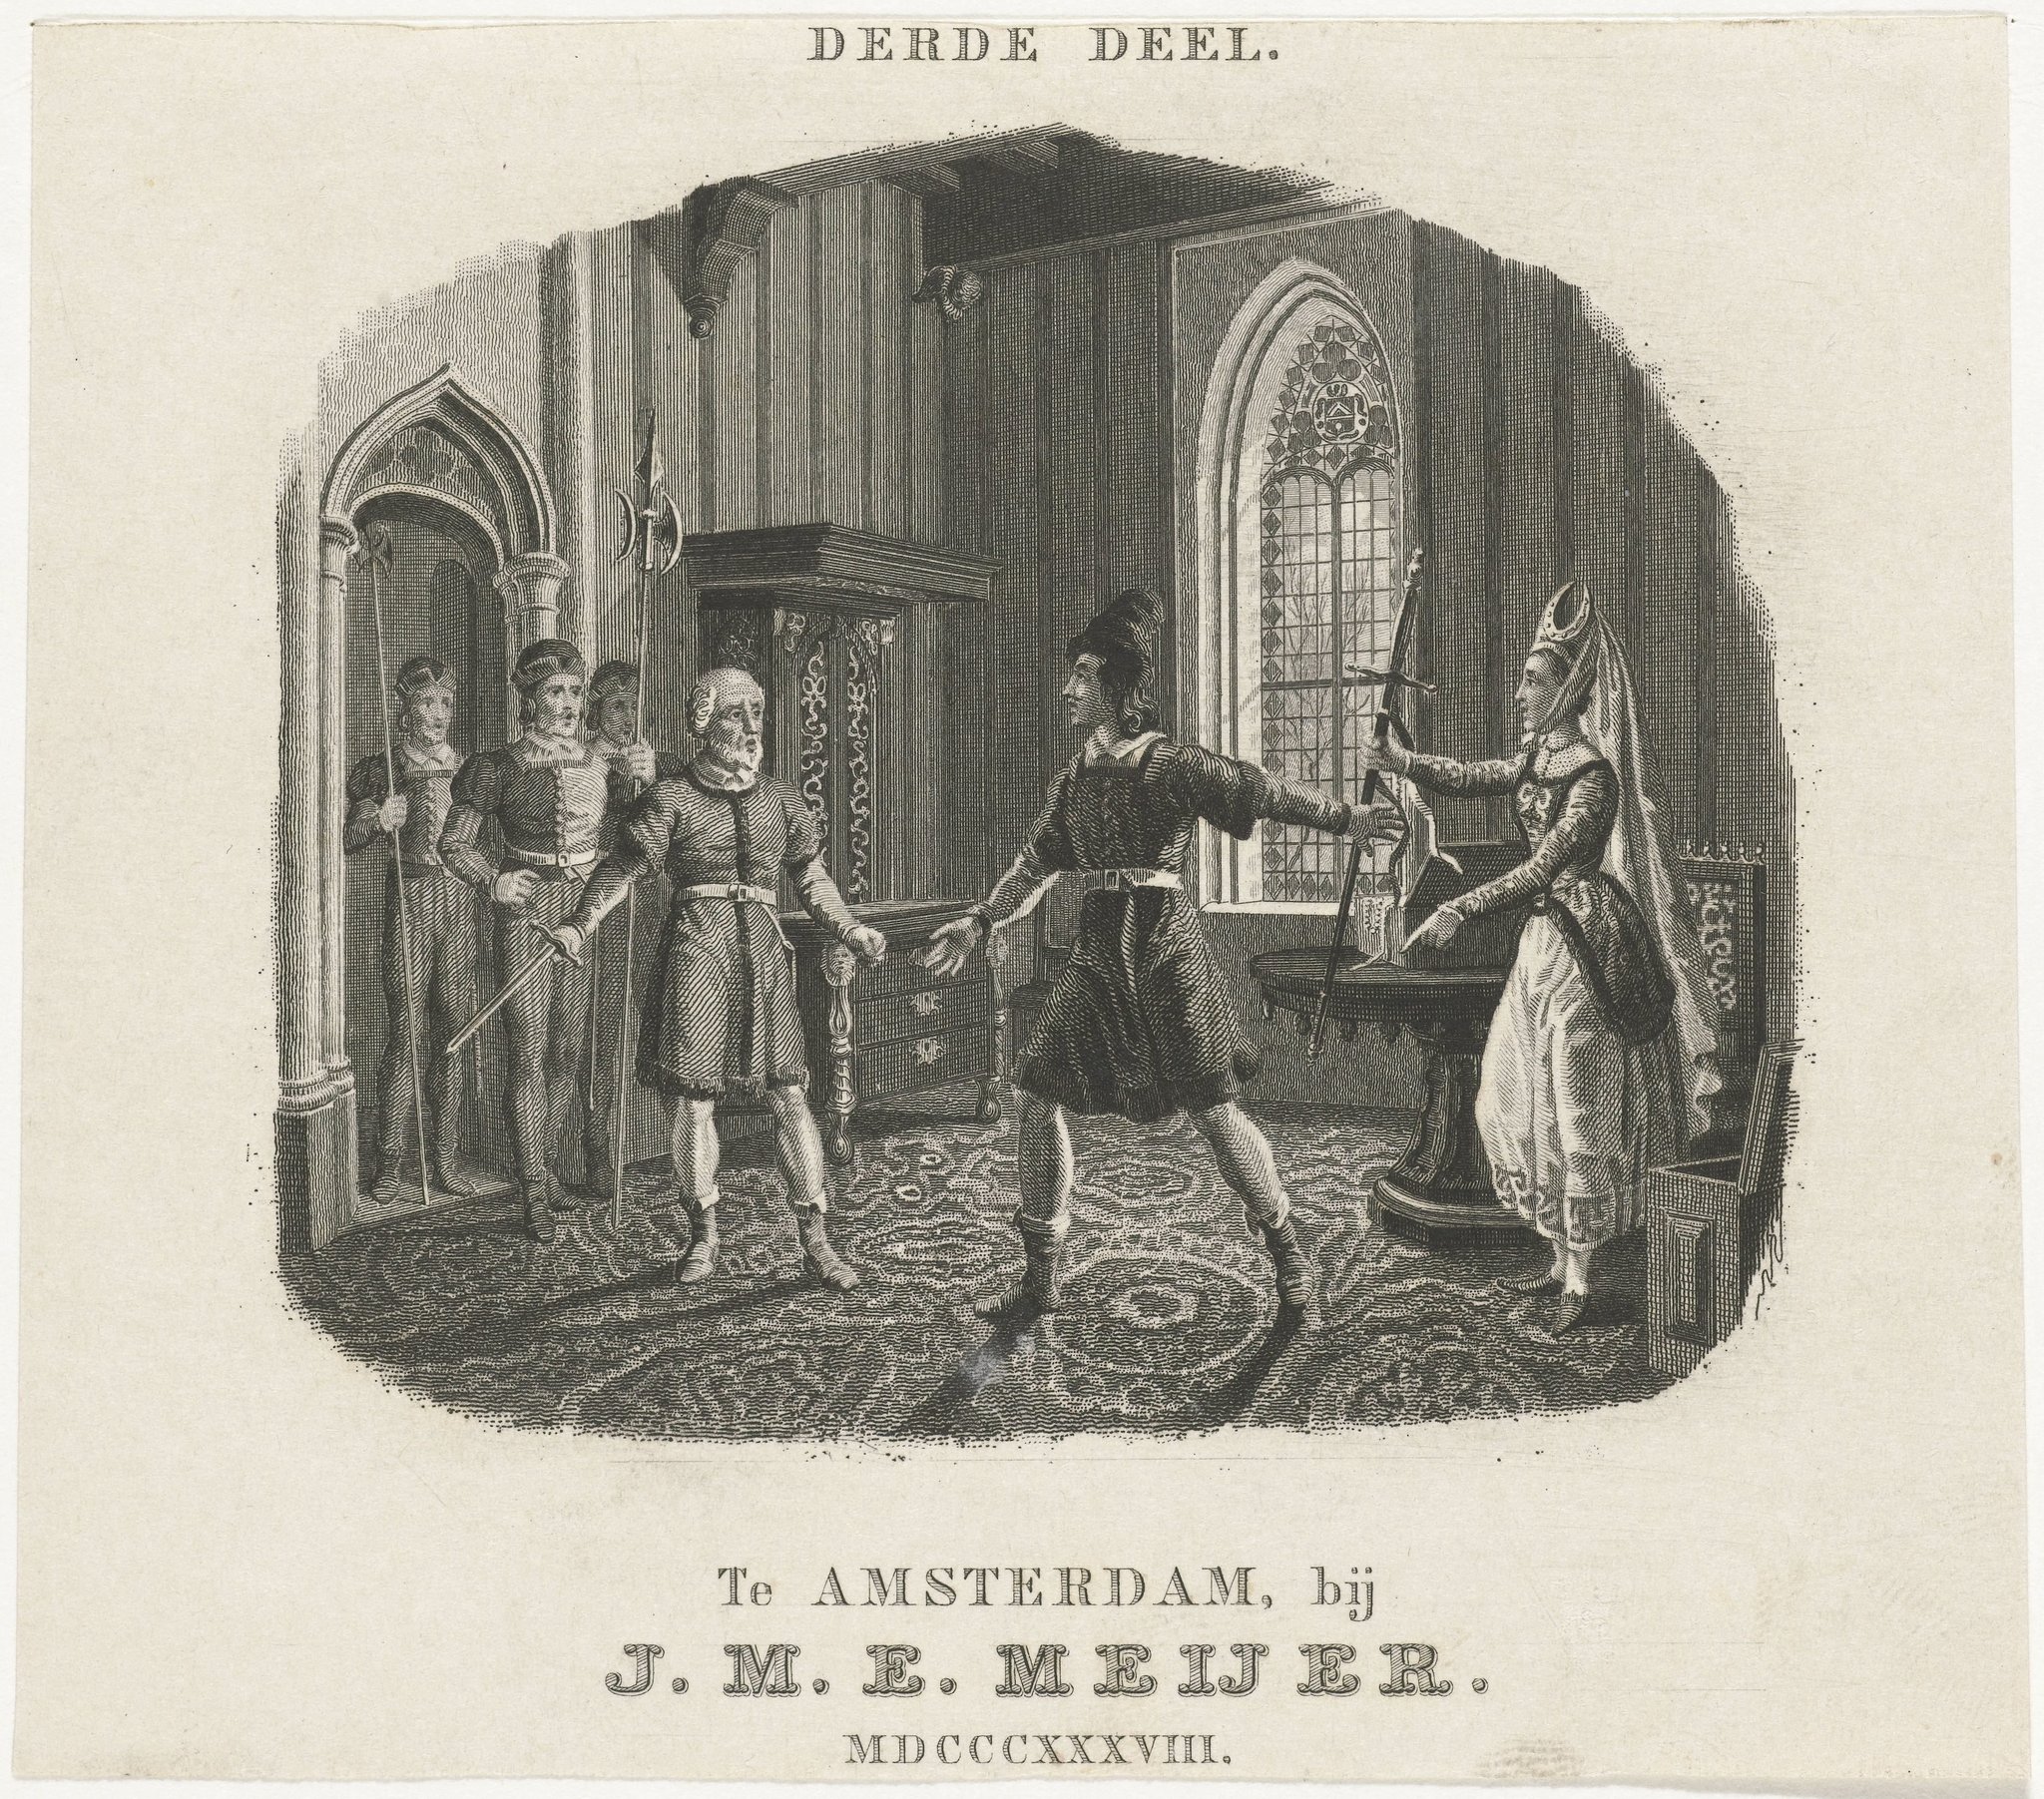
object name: book illustration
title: Vrouw reikt haar man zijn zwaard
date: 1838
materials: paper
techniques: engraving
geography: amsterdam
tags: preparation for battle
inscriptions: collector's mark: Lugt 2228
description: Een oude man stapt met drie mannen van een garde een gotische kamer binnen en roept de huisheer op om met hem mee te gaan. De vrouw reikt de man haastig zijn zwaard.